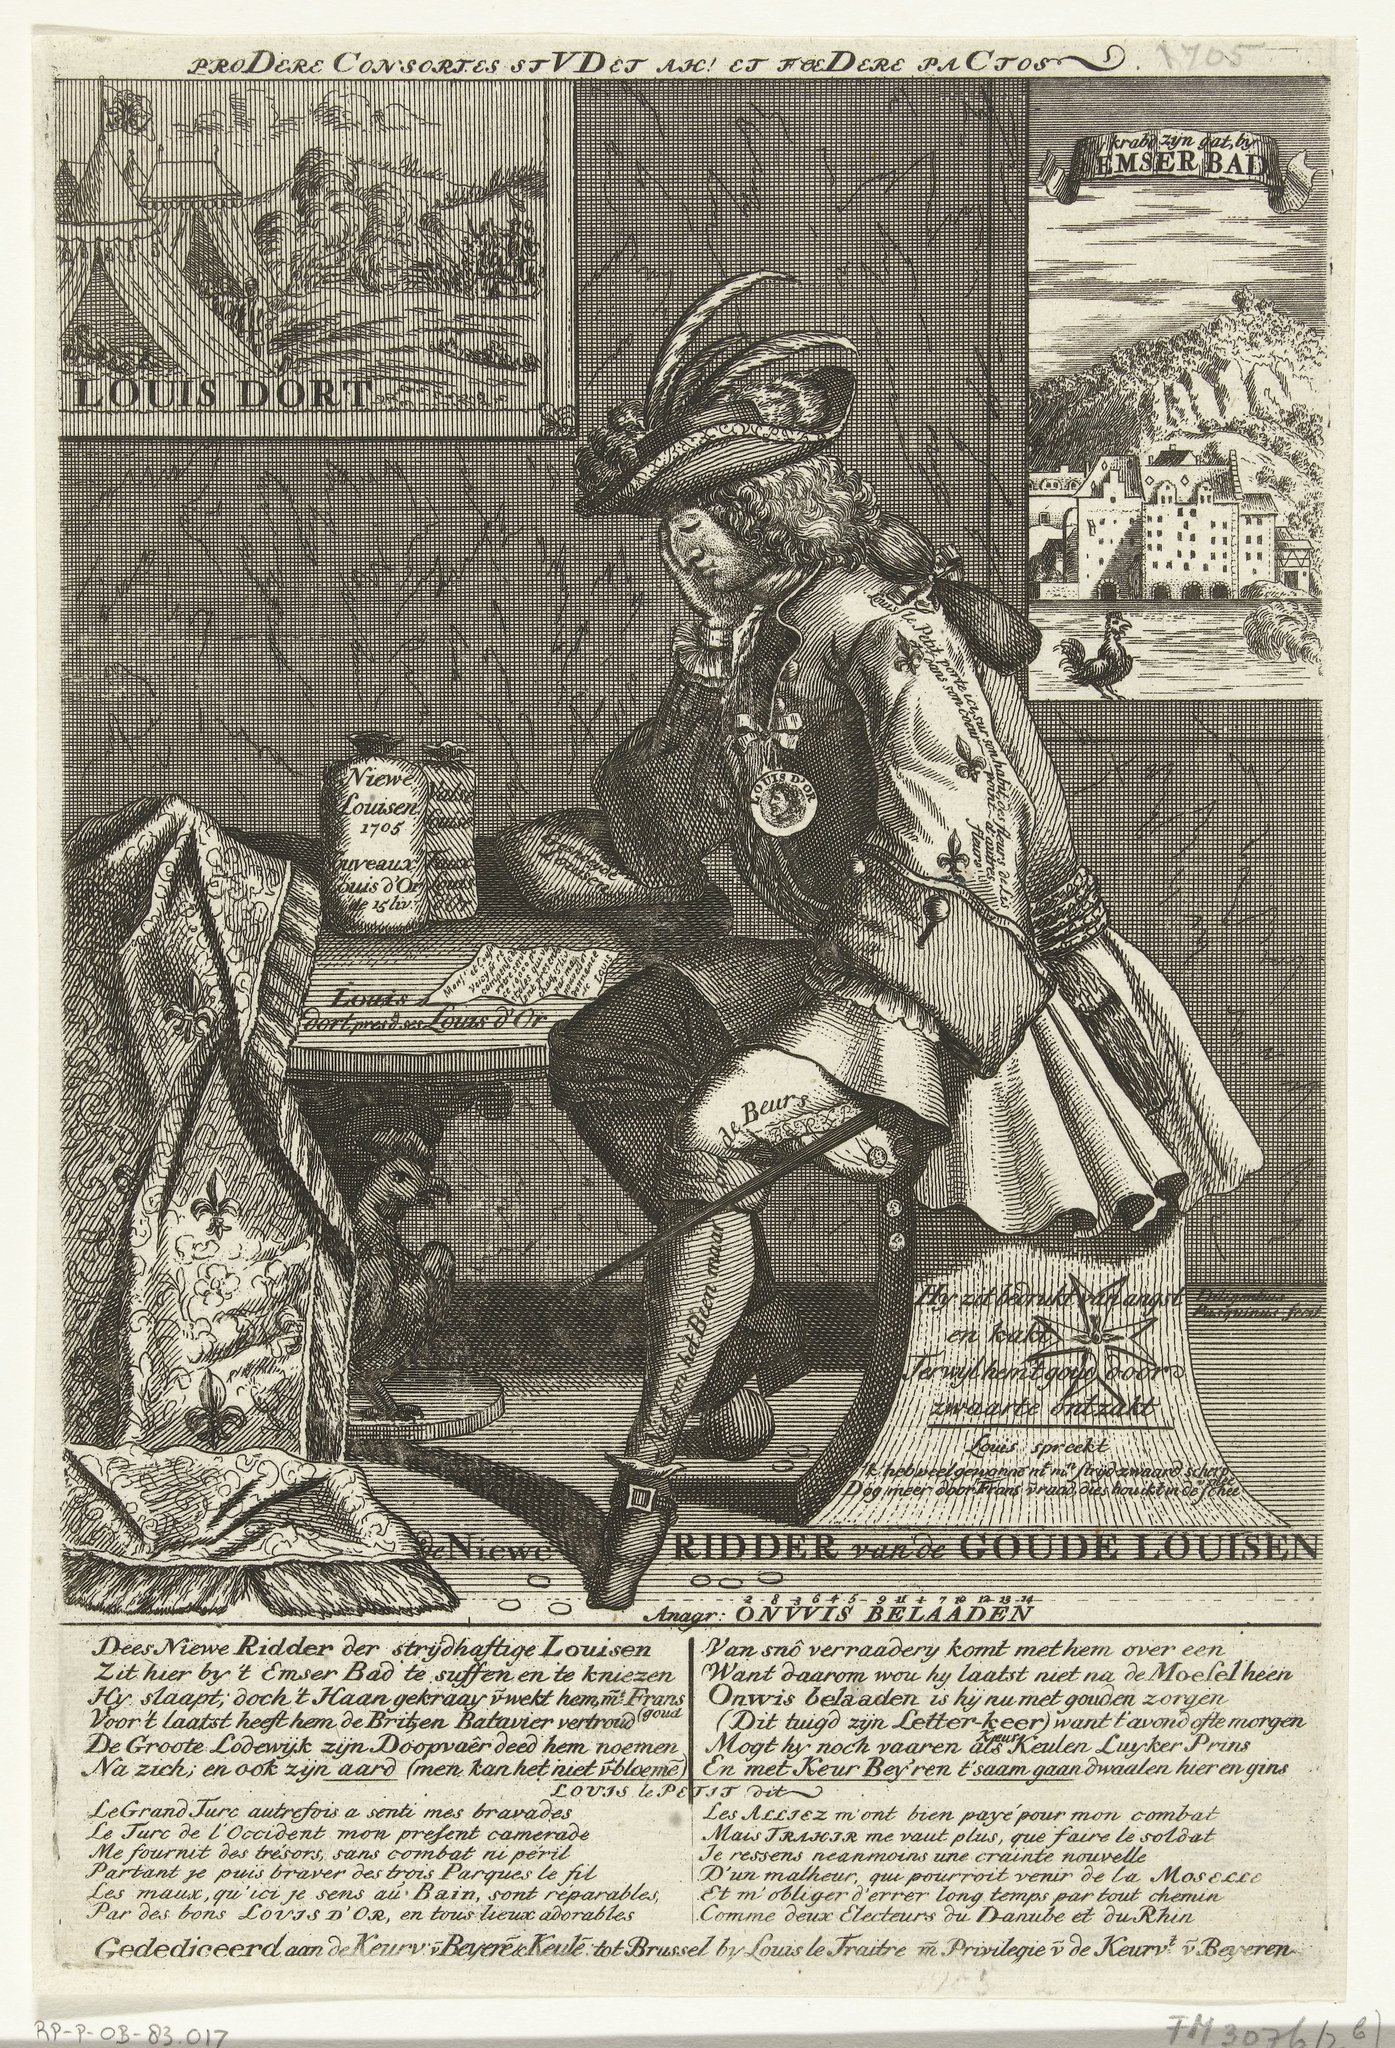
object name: cartoon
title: Koninklijke Almanach van 1705 / 't Lusthof van Momus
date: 1705-1706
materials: paper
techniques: etching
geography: northern netherlands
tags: political caricatures and satires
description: Spotprent op Lodewijk Willem, markgraaf van Baden-Baden, omgekocht naar Franse zijde door koning Lodewijk XIV. De markgraaf slapend aan een tafel met goudstukken. In het onderschrift verzen in het Nederlands en Frans. Onderdeel van een reeks van 7 spotprenten op de Fransen en bondgenoten uit het jaar 1705.